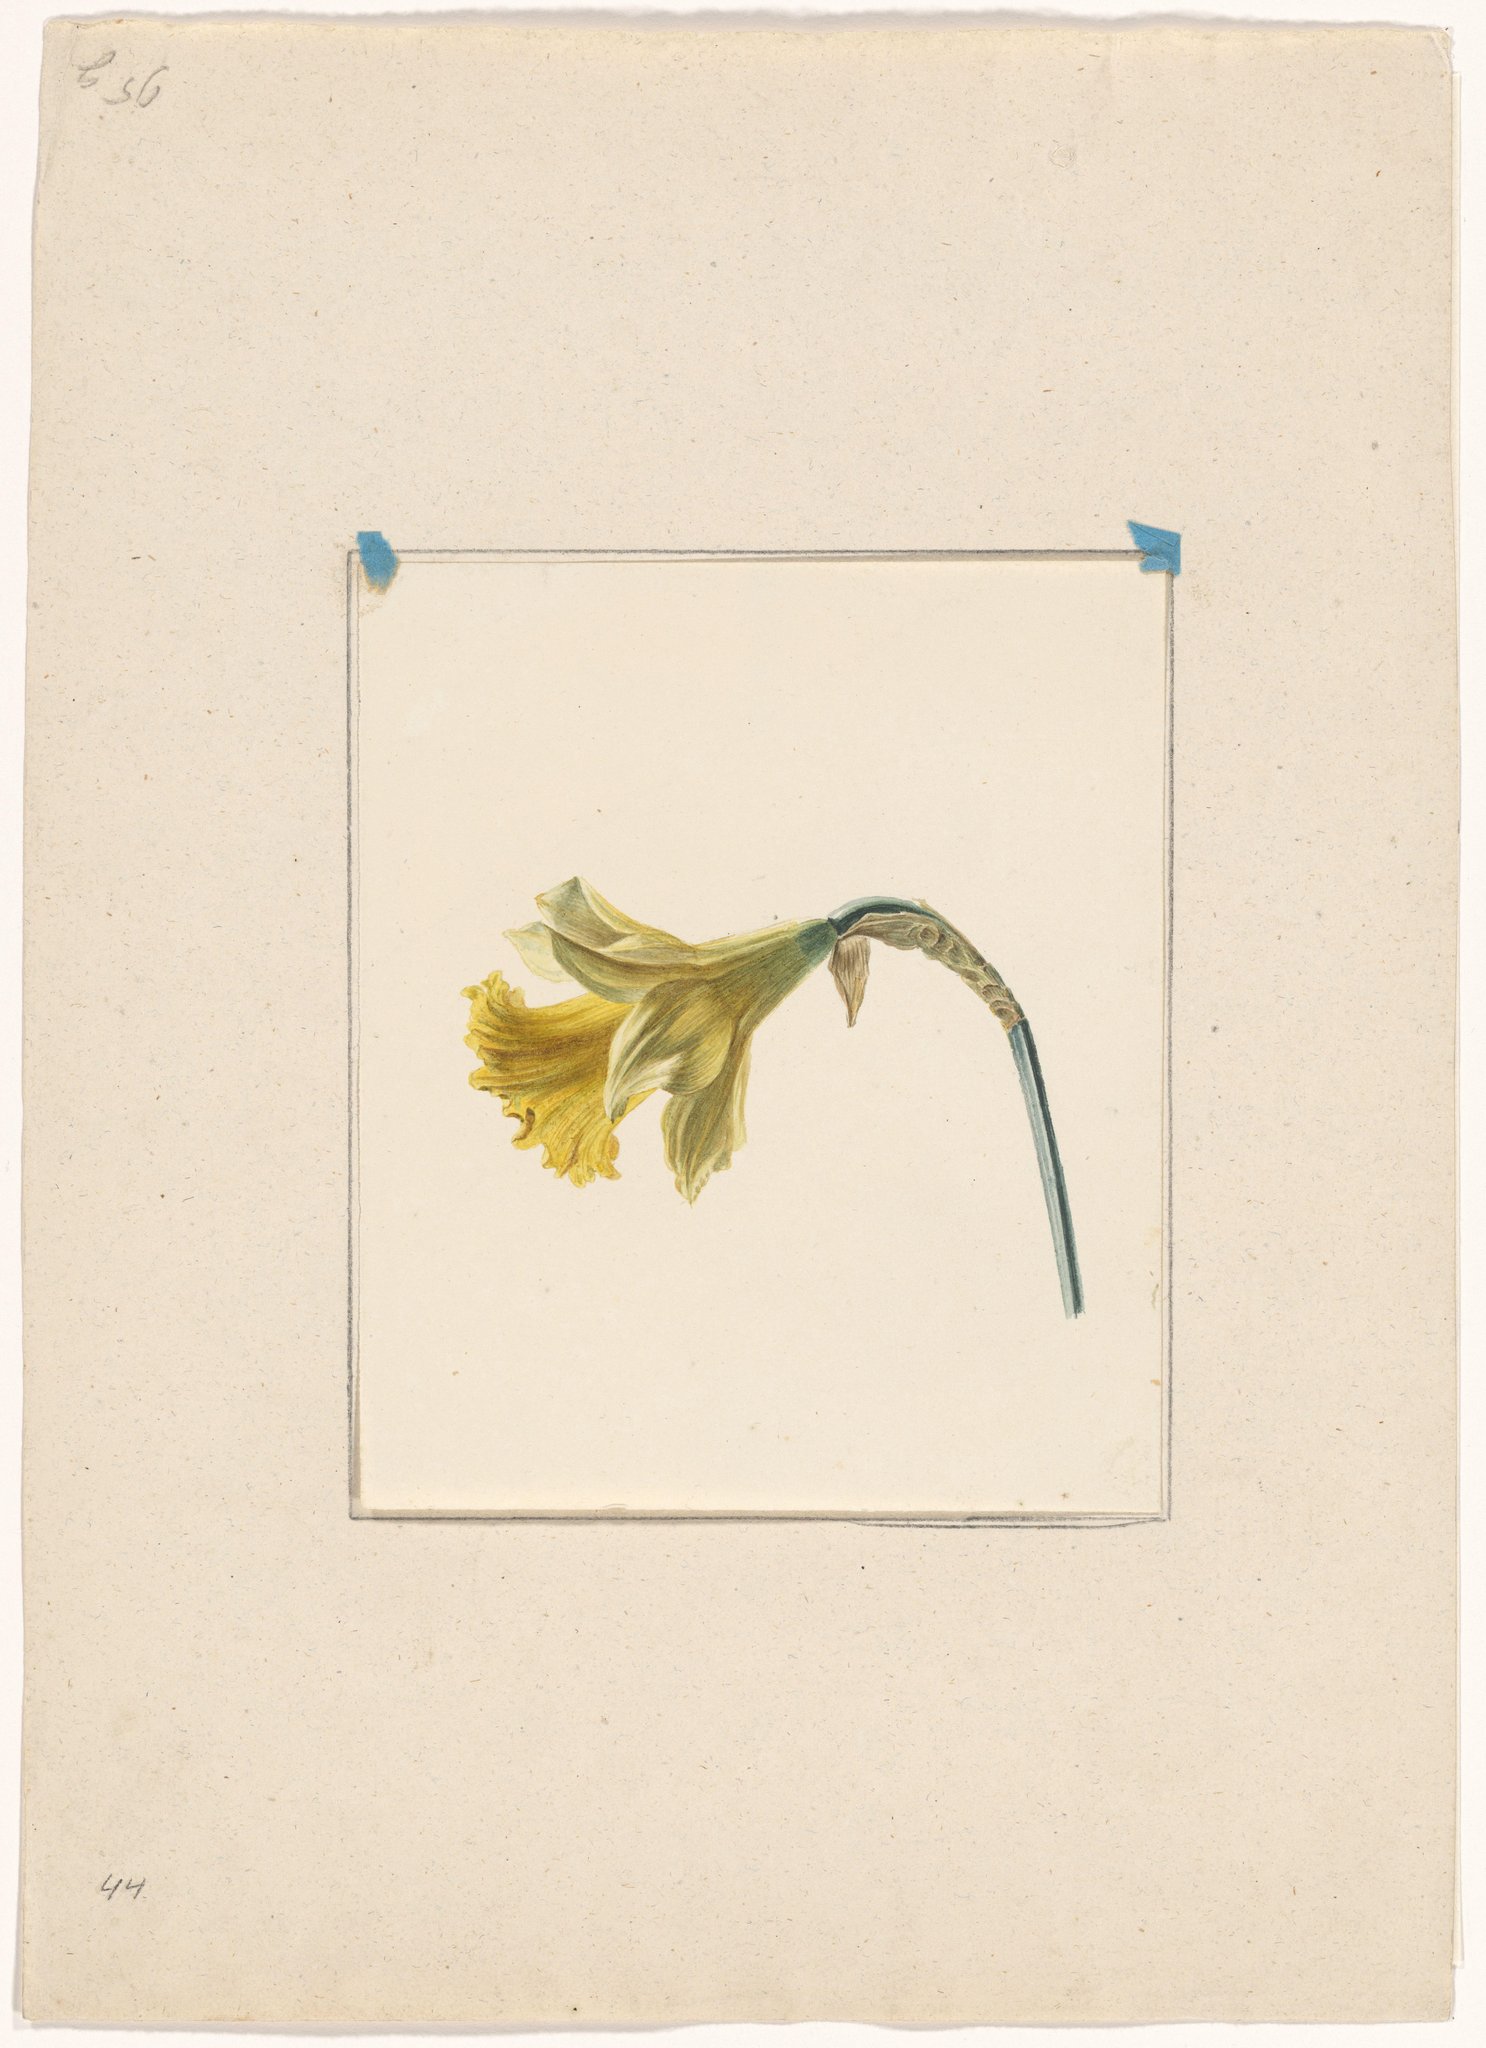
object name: drawing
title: Narcis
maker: eelke jelles eelkema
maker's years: 1788-1839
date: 1815-1830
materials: paper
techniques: drawing